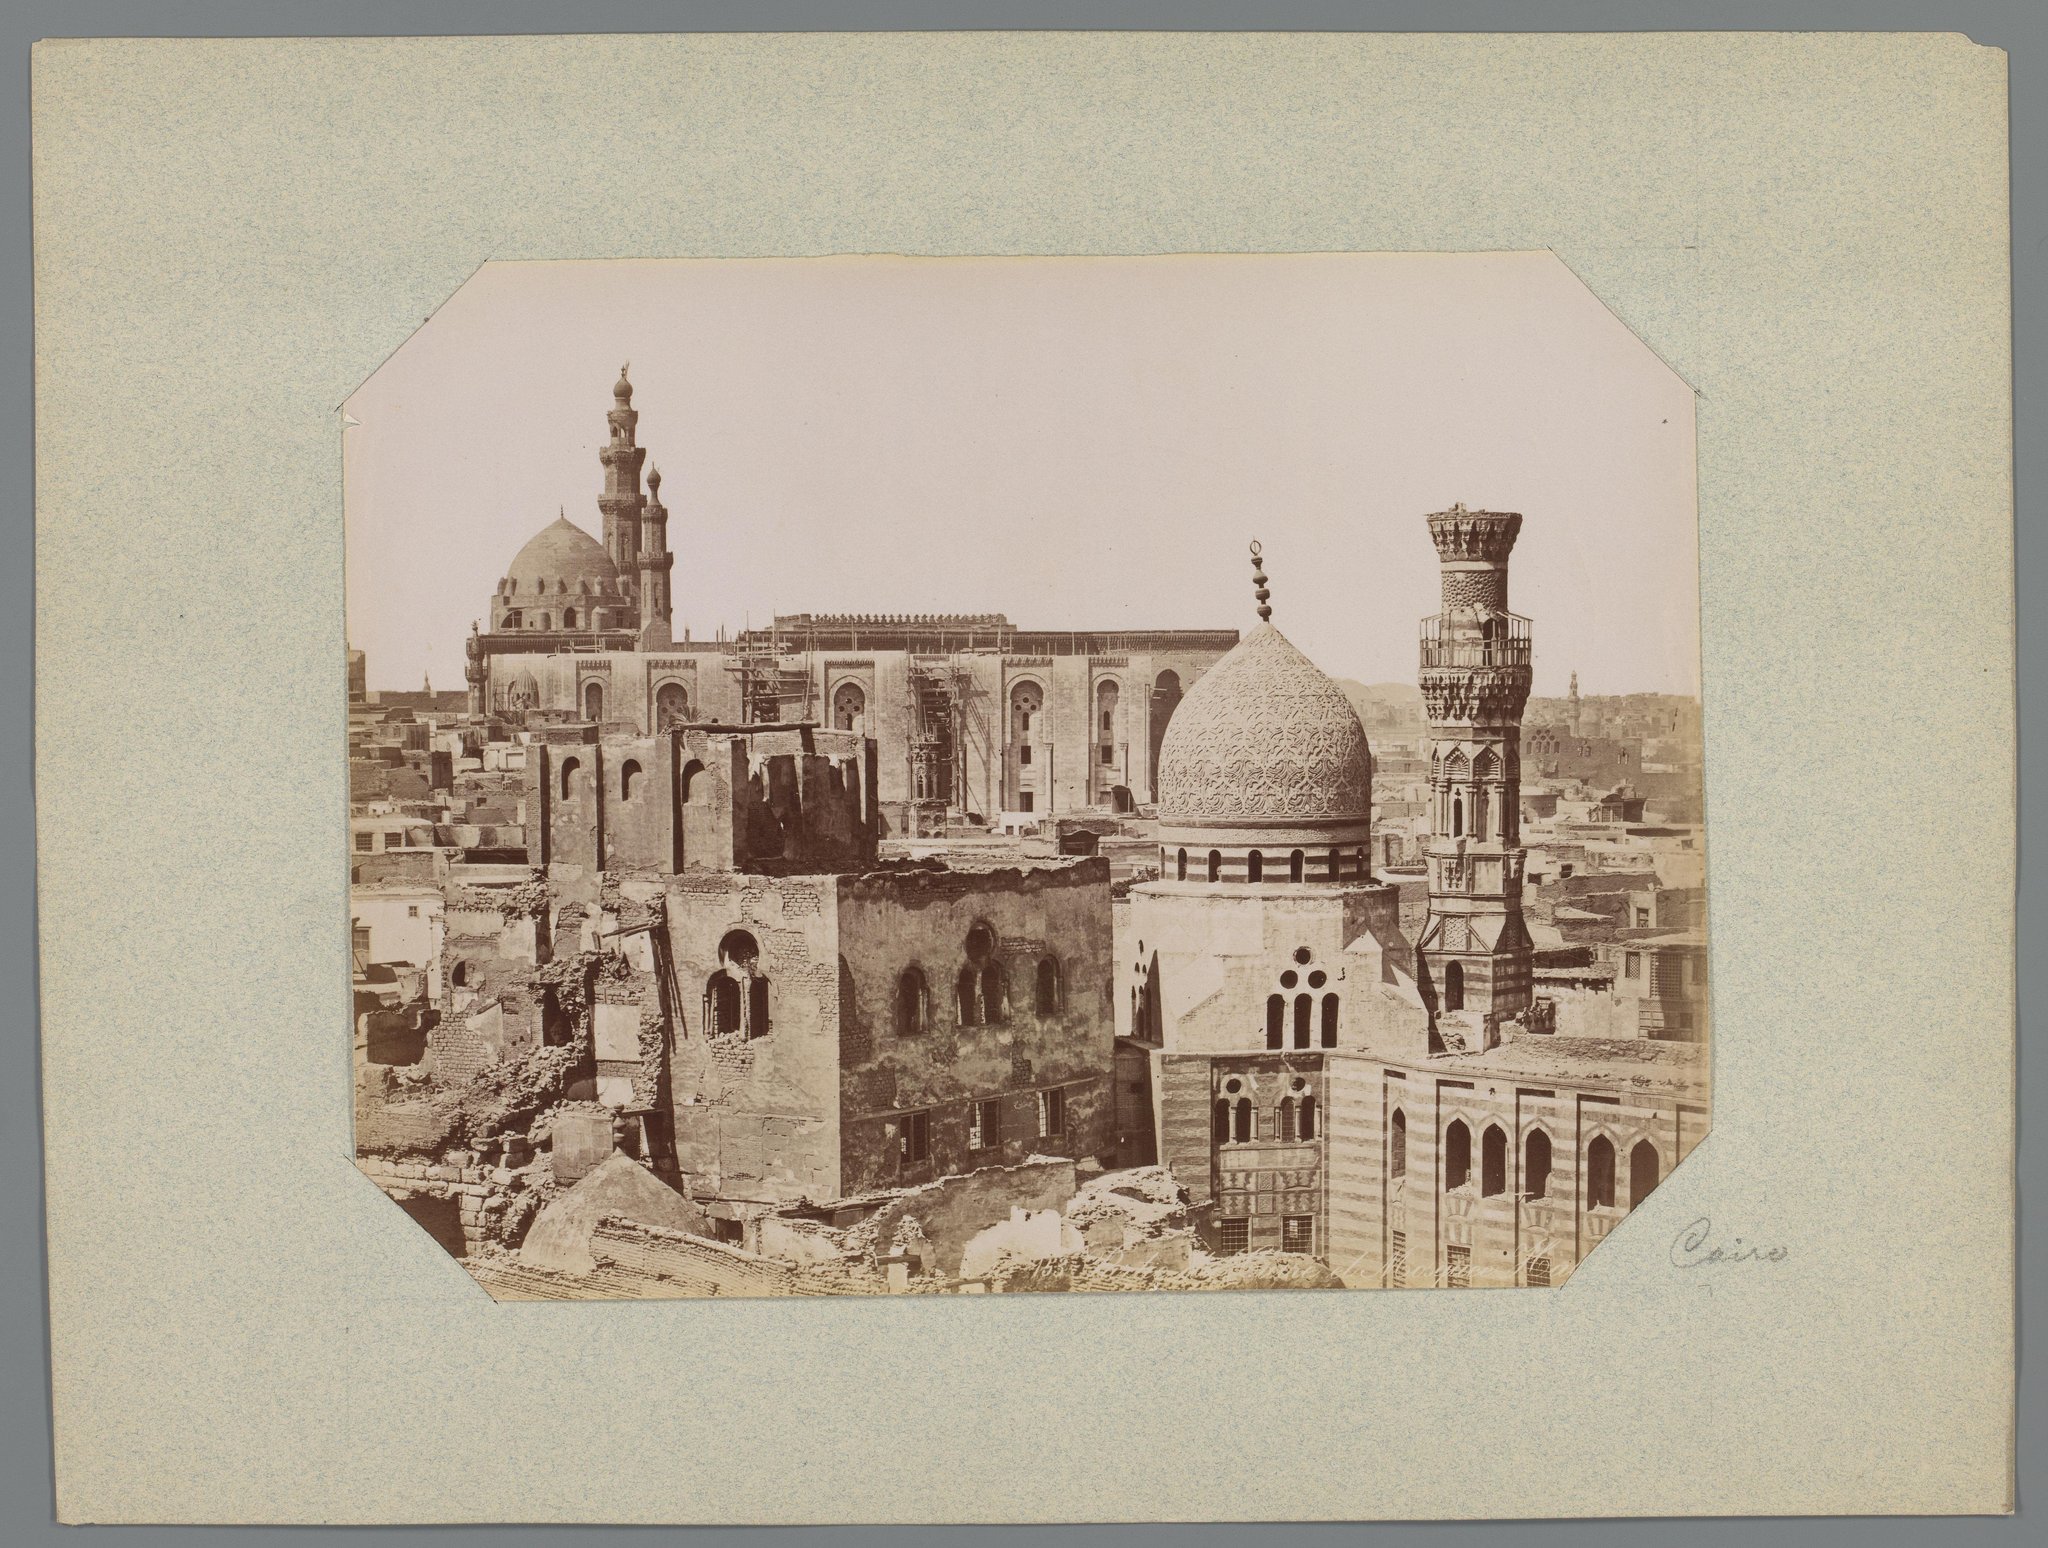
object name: photograph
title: Madrassa-moskee van Sultan Hassan in Caïro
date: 1870-1910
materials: cardboard, paper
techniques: albumen print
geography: cairo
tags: temple, shrine ~ islam, mohammedanism, mosque-madrasa of sultan hassan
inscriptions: number: ‘No 153’